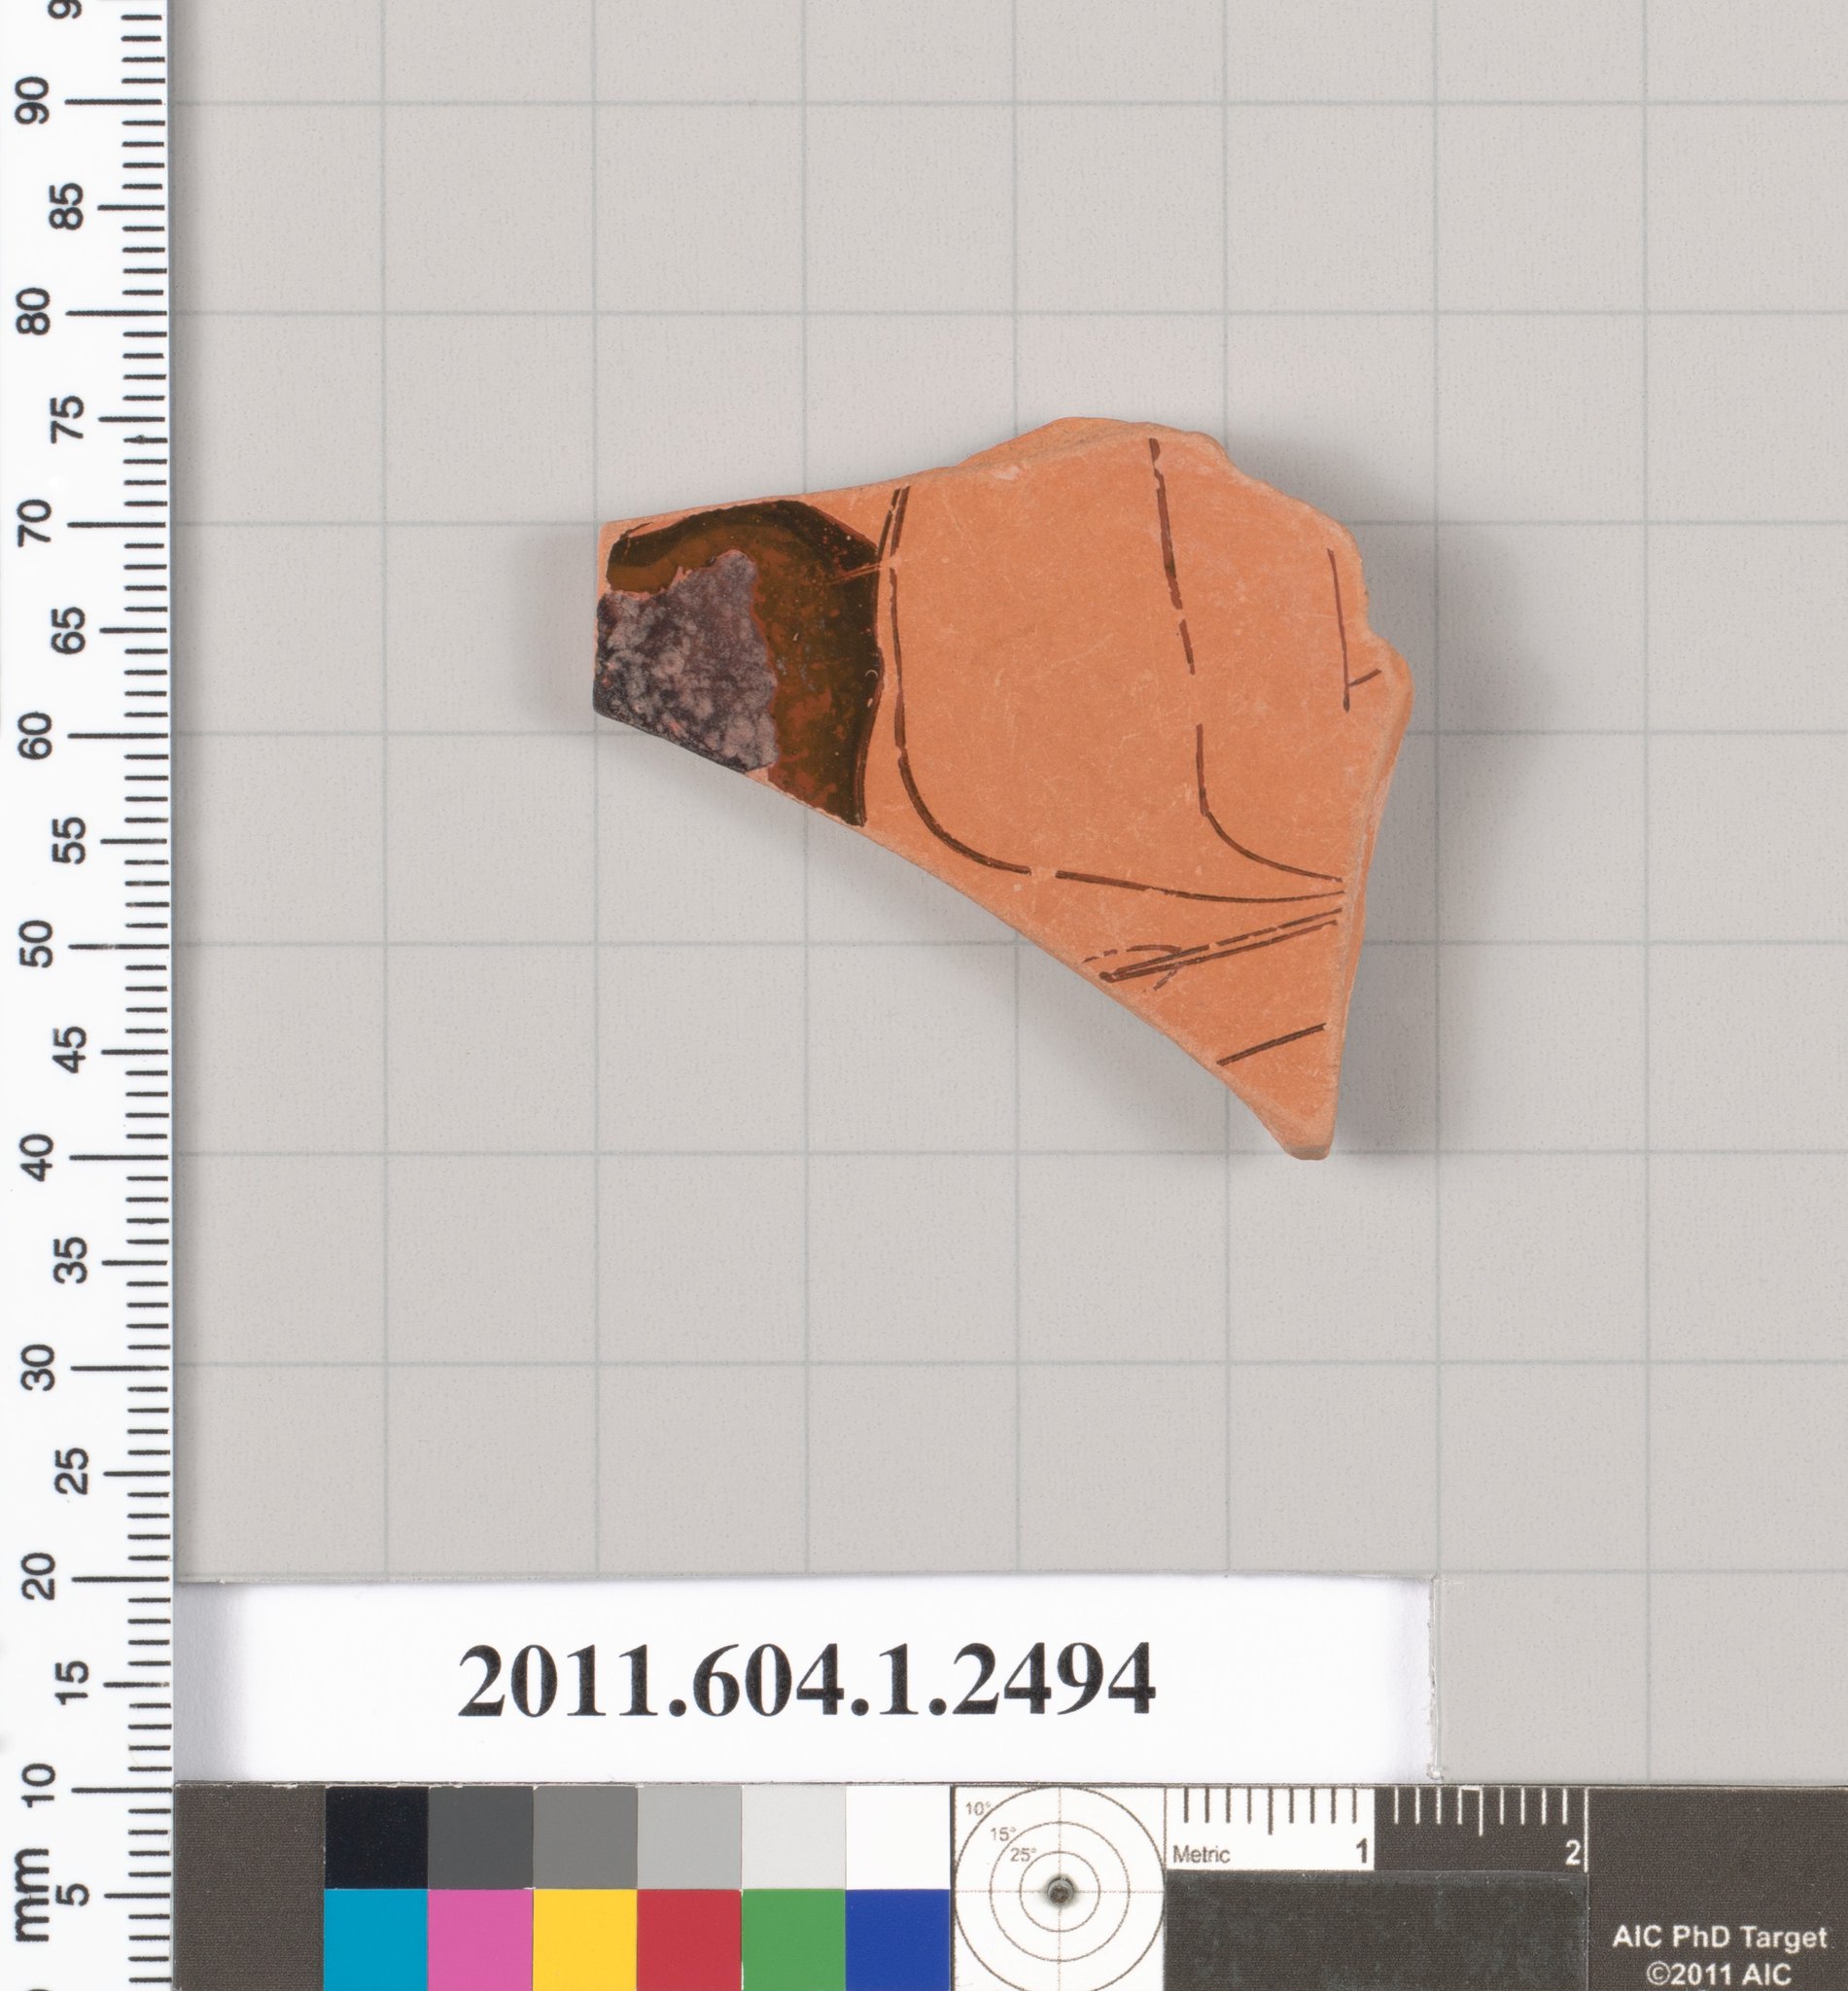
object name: kylix fragment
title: Terracotta fragment of a kylix (drinking cup)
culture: greek, attic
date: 475-451 BCE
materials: terracotta